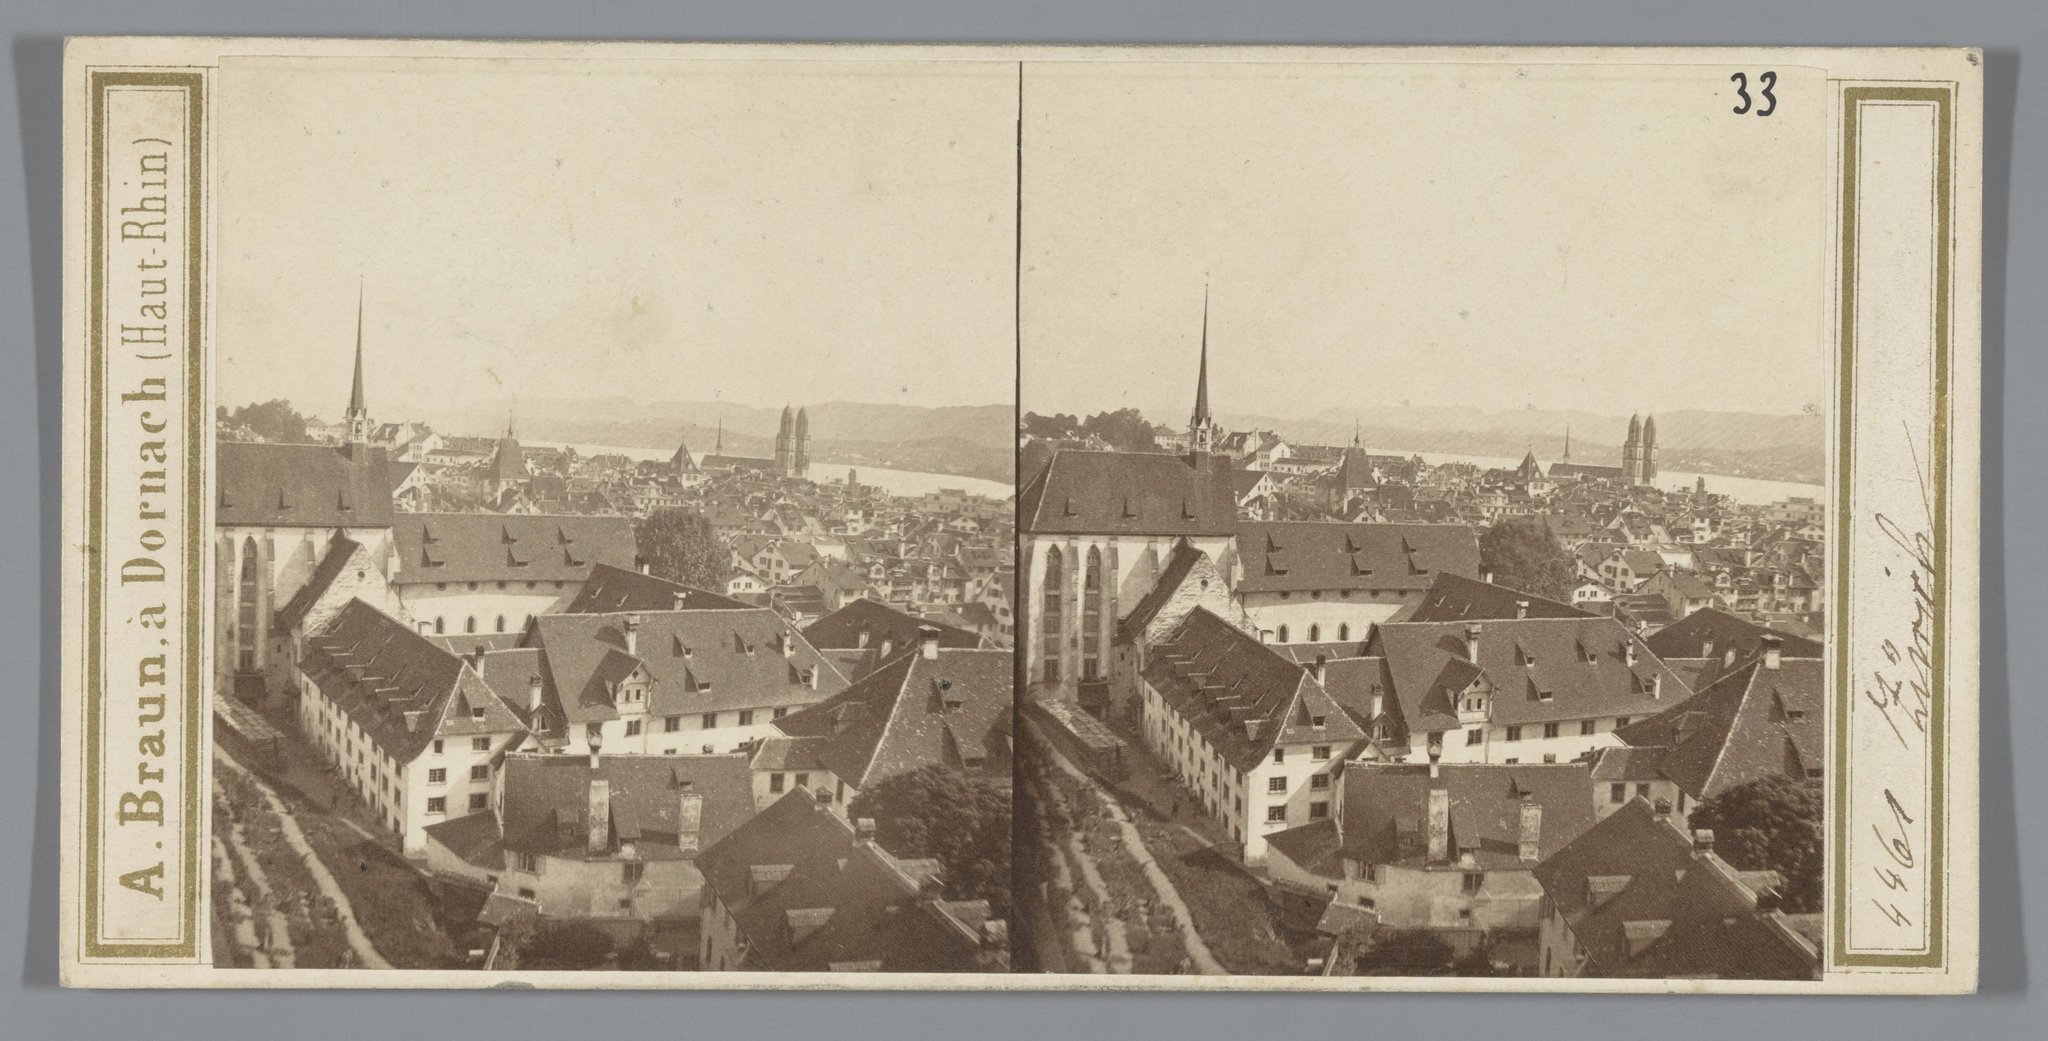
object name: stereograph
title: Gezicht op Zürich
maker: Anonymous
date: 1860-1866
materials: cardboard, paper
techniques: albumen print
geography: dornach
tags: city-view in general; 'veduta'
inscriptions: number: ‘4461’, number: ‘33’